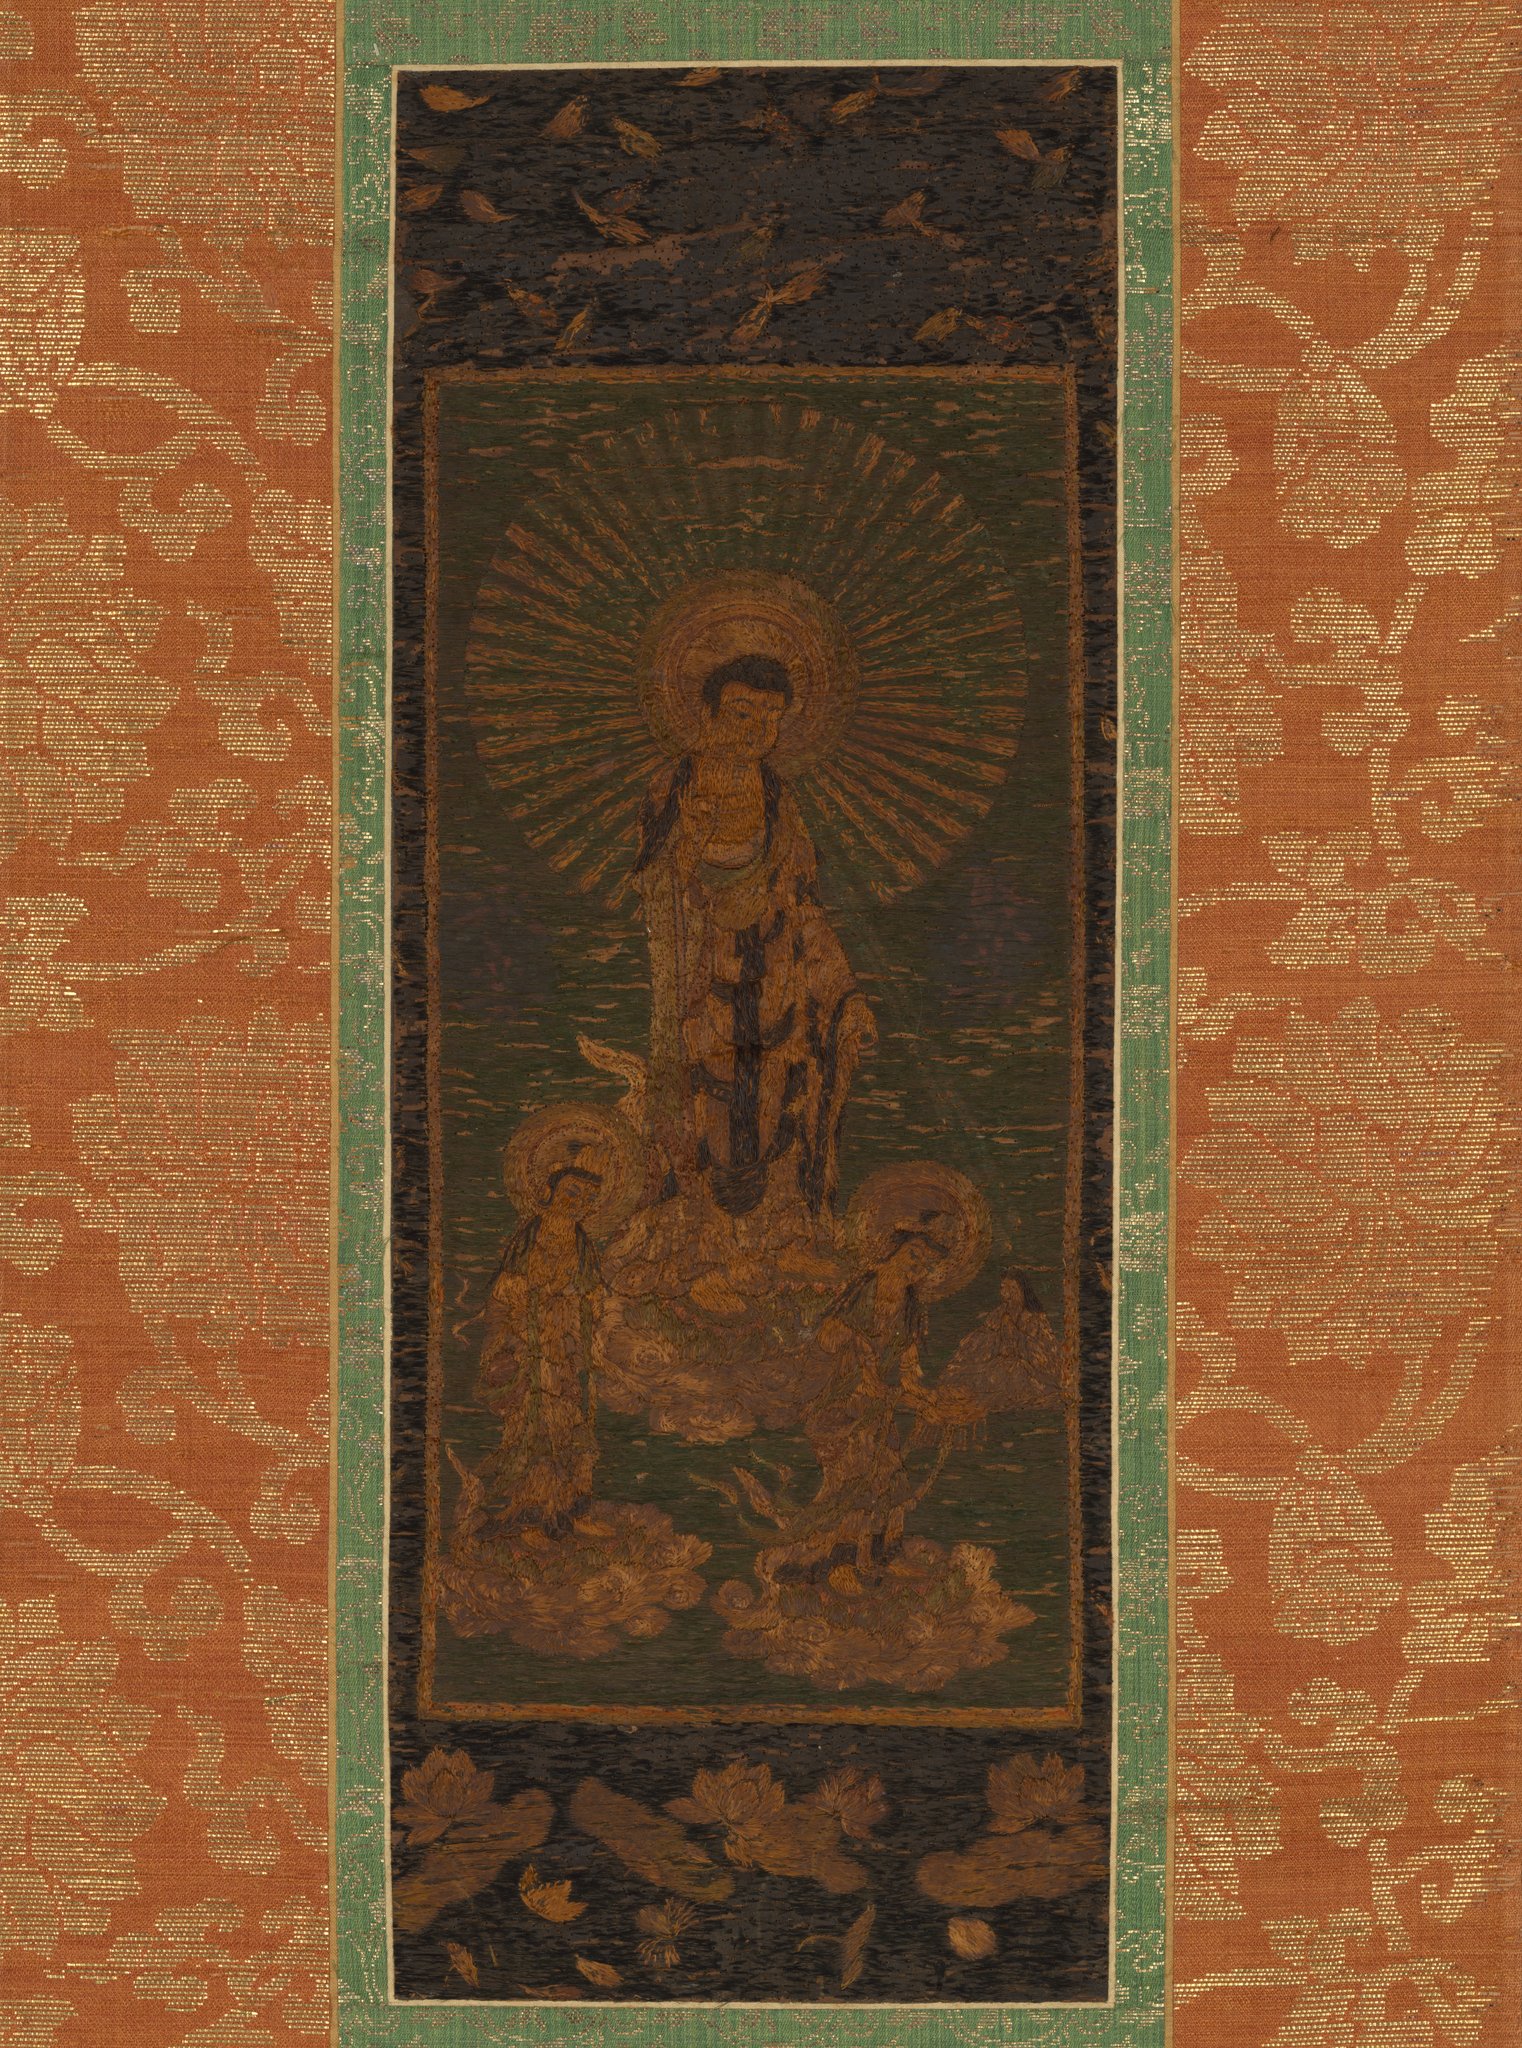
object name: hanging scroll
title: Welcoming Descent of Amida Buddha with Bodhisattvas Kannon and Seishi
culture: japanese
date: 1367-1433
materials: hair, silk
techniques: embroidery